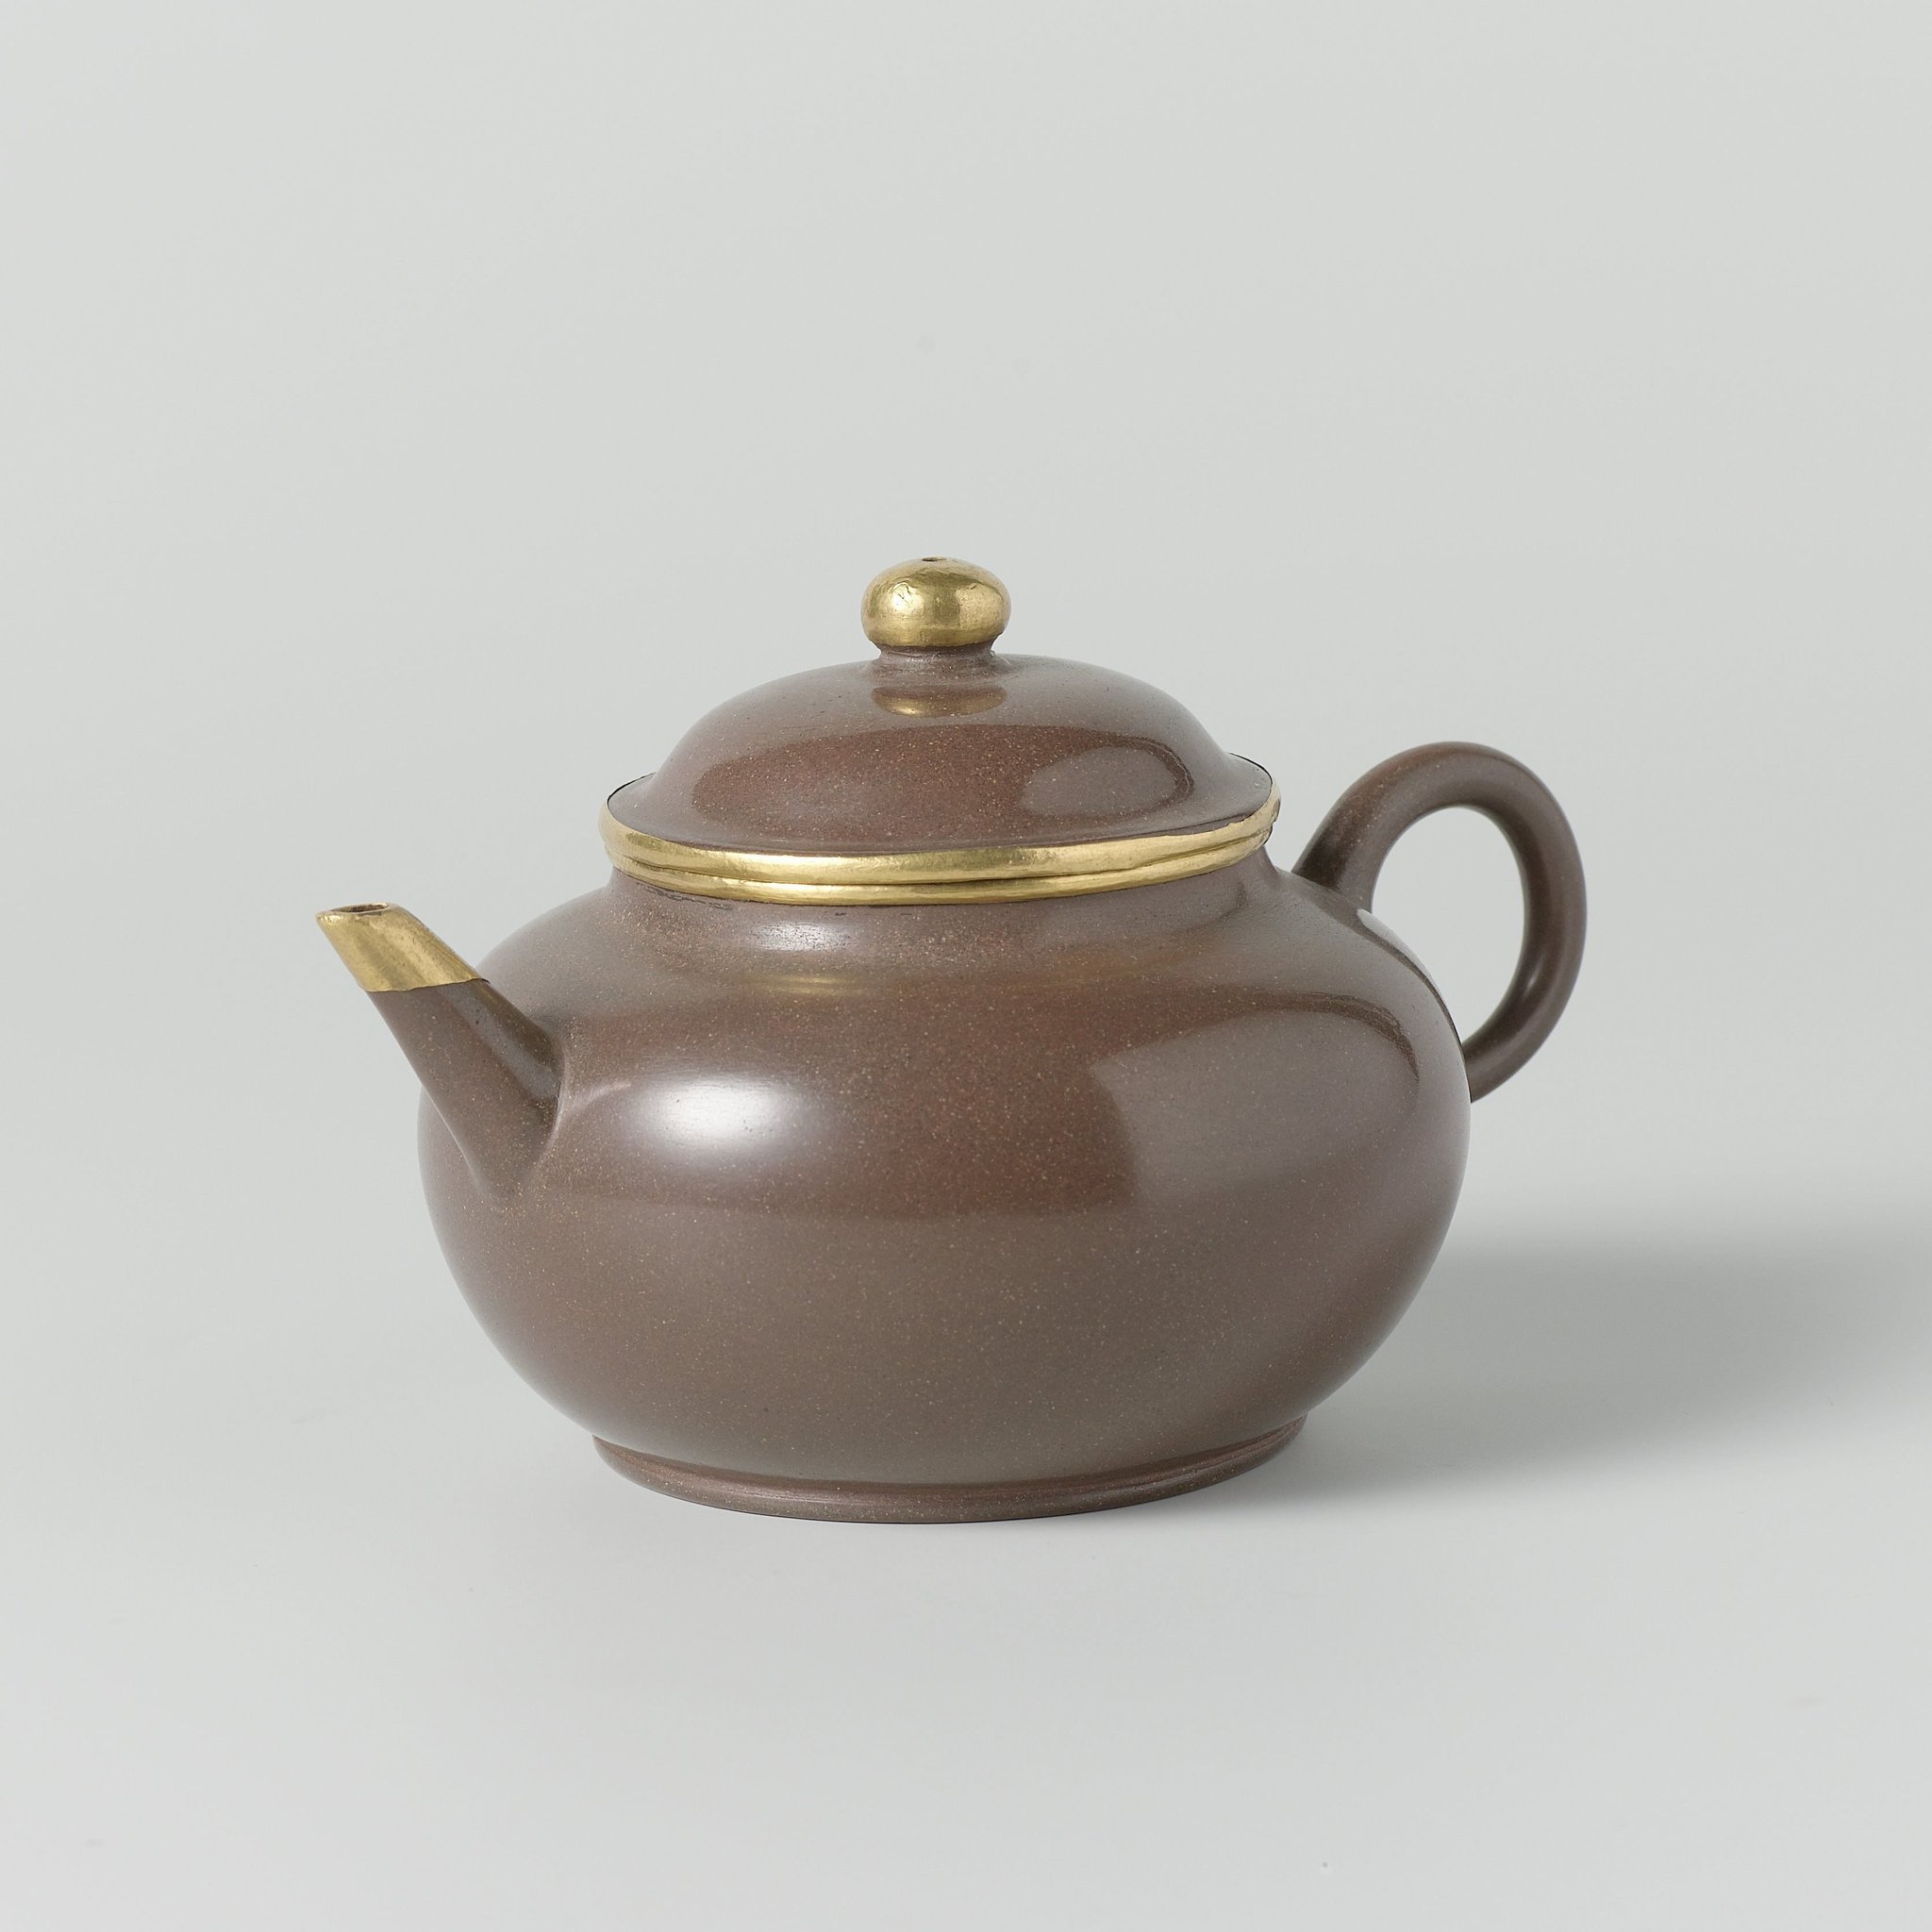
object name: teapot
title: tea pot of red stoneware with gold rims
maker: Anonymous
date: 1800-1899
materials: gold, stoneware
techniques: firing, polish, turning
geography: china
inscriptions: mark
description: Theepot van bruinrood steengoed met een rechte tuit, C-vormig oor en vergulde randen, dekselknop en uiteiden van de tuit. De wanden van de pot zijn gepolijst. Gemerkt op de onderzijde en onder het oor met ongeïdentificeerde merken. Dit type pot werd speciaal voor het Thaise hof geproduceerd. Yixing.